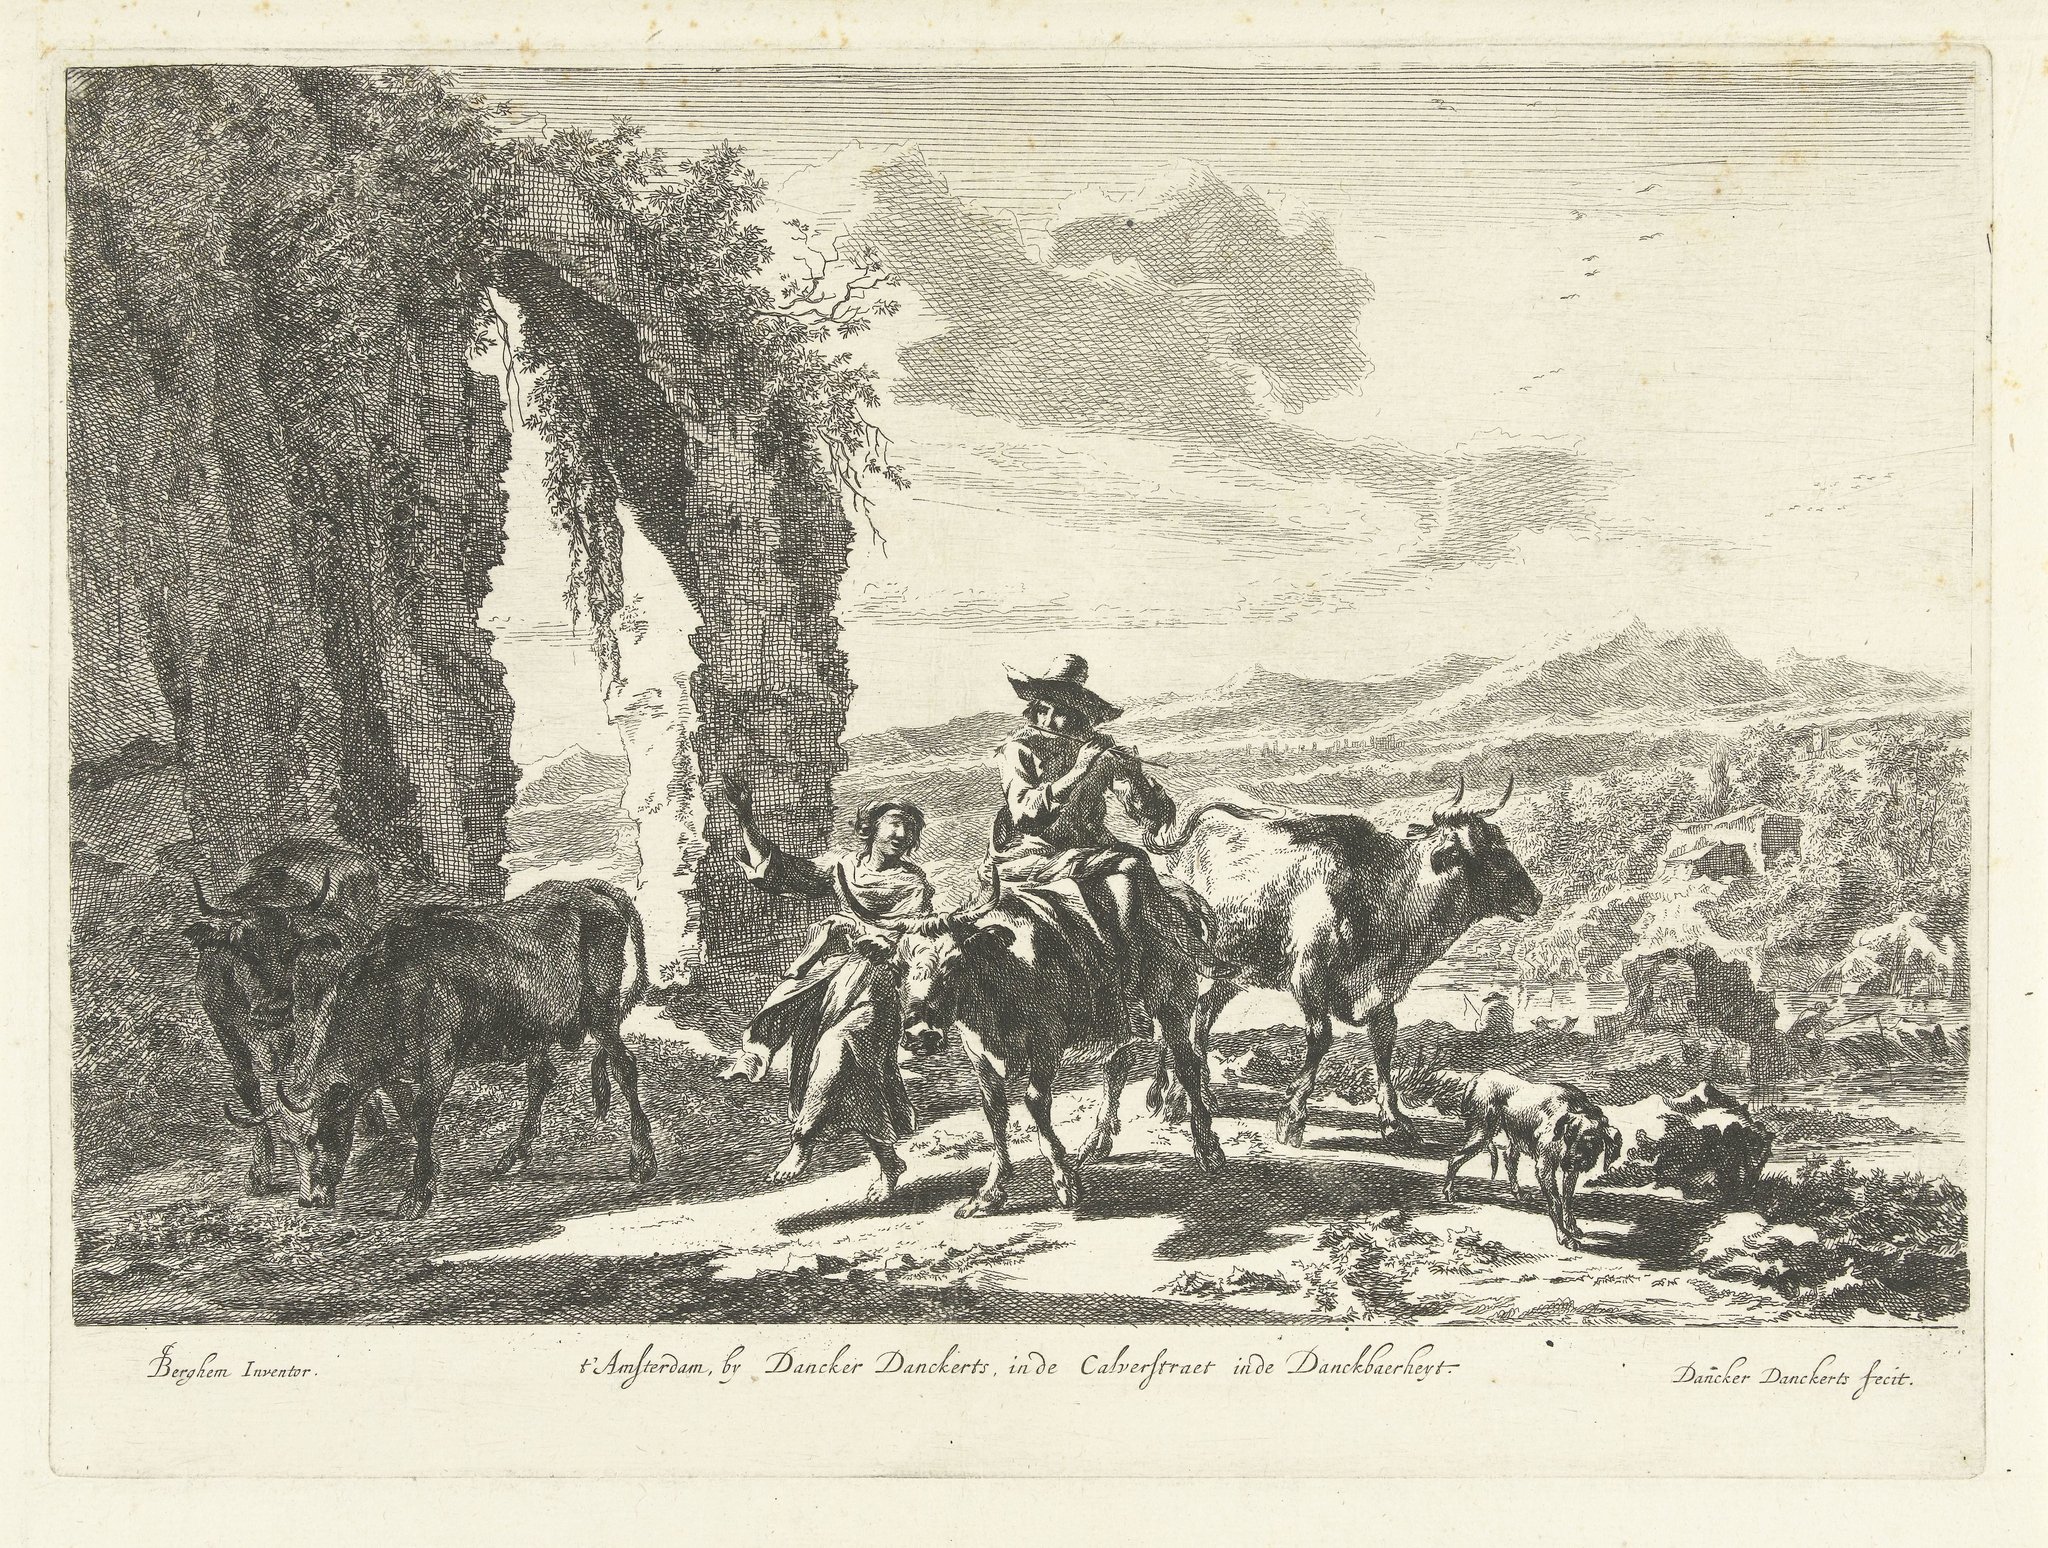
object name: print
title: Herders met vee bij ruïne in berglandschap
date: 1643-1666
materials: paper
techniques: etching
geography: amsterdam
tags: herding, herdsman, herdswoman, shepherd, shepherdess, cowherd, etc., rocks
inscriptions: collector's mark: Lugt 240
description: Herder zit op de rug van een koe en speelt fluit terwijl herderin danst. Koeien grazen om hen heen bij een ruïneboog in een berglandschap.